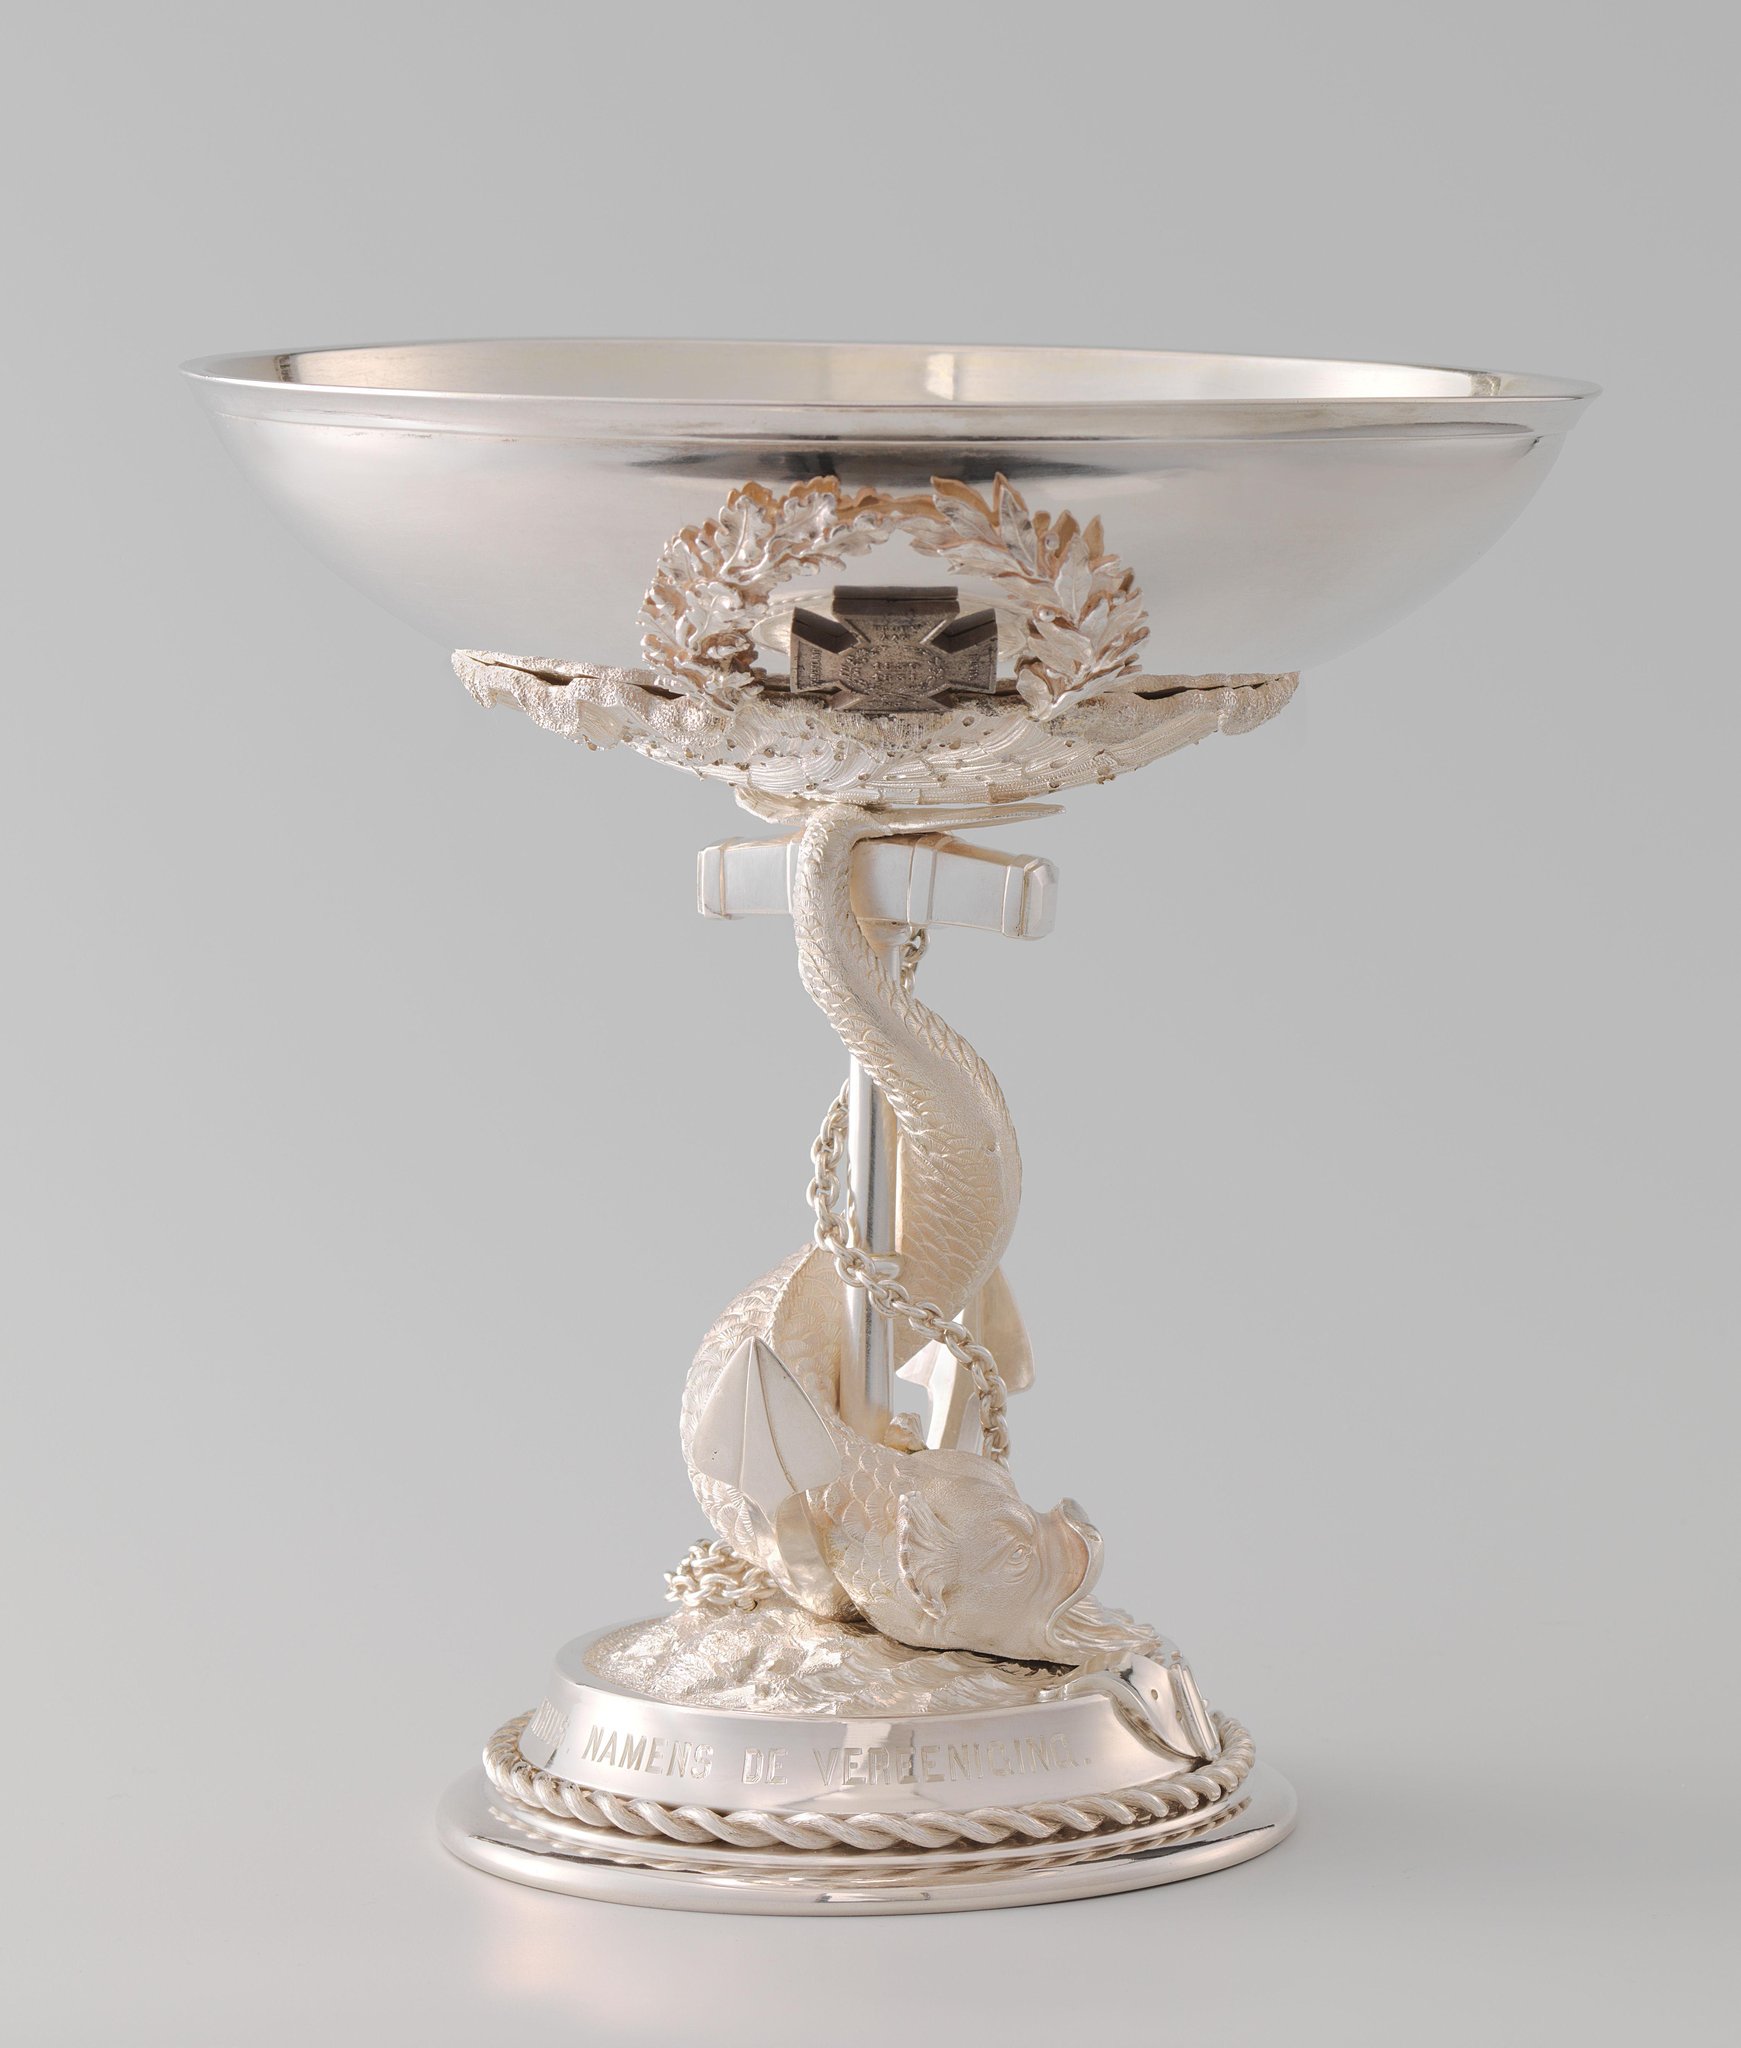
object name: goblet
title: Silver Cup of the Society 'Het Metalen Kruis'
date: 1863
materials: silver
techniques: casting, metalworking, gilding, screwed, soldering, striking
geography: voorschoten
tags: metalen kruis, metalen kruis (schip), shimonoseki, straat van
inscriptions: mark: ‘VK’ Minerva head, mark: several marks, inscription, on the anchor: ‘2 Dec 1863’, inscription, on the base: ‘AAN Z.M. SCHROEF STOOMSCHIP HET METALEN KRUIS NAMENS DE VEREENIGING.’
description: De Vereniging 'Het Metalen Kruis' werd opgericht ter herinnering aan de wapenfeiten rond de Belgische Opstand, het kruis zijnde een onderscheiding voor deelnemers aan die actie. De beker werd door de vereniging in 1865 geschonken aan het schroefstoomschip van dezelfde naam ter herinnering aan de actie in de Straat van Simonoseki in 1864, waarbij het de Medusa te hulp kwam bij het breken van de Japanse blokkade. Na de verkoop van het schroefstoomschip Z.M. Het Metalen Kruis werd de beker op 22 november 1880 in de Modelkamer van het Ministerie van Marine gedeponeerd.